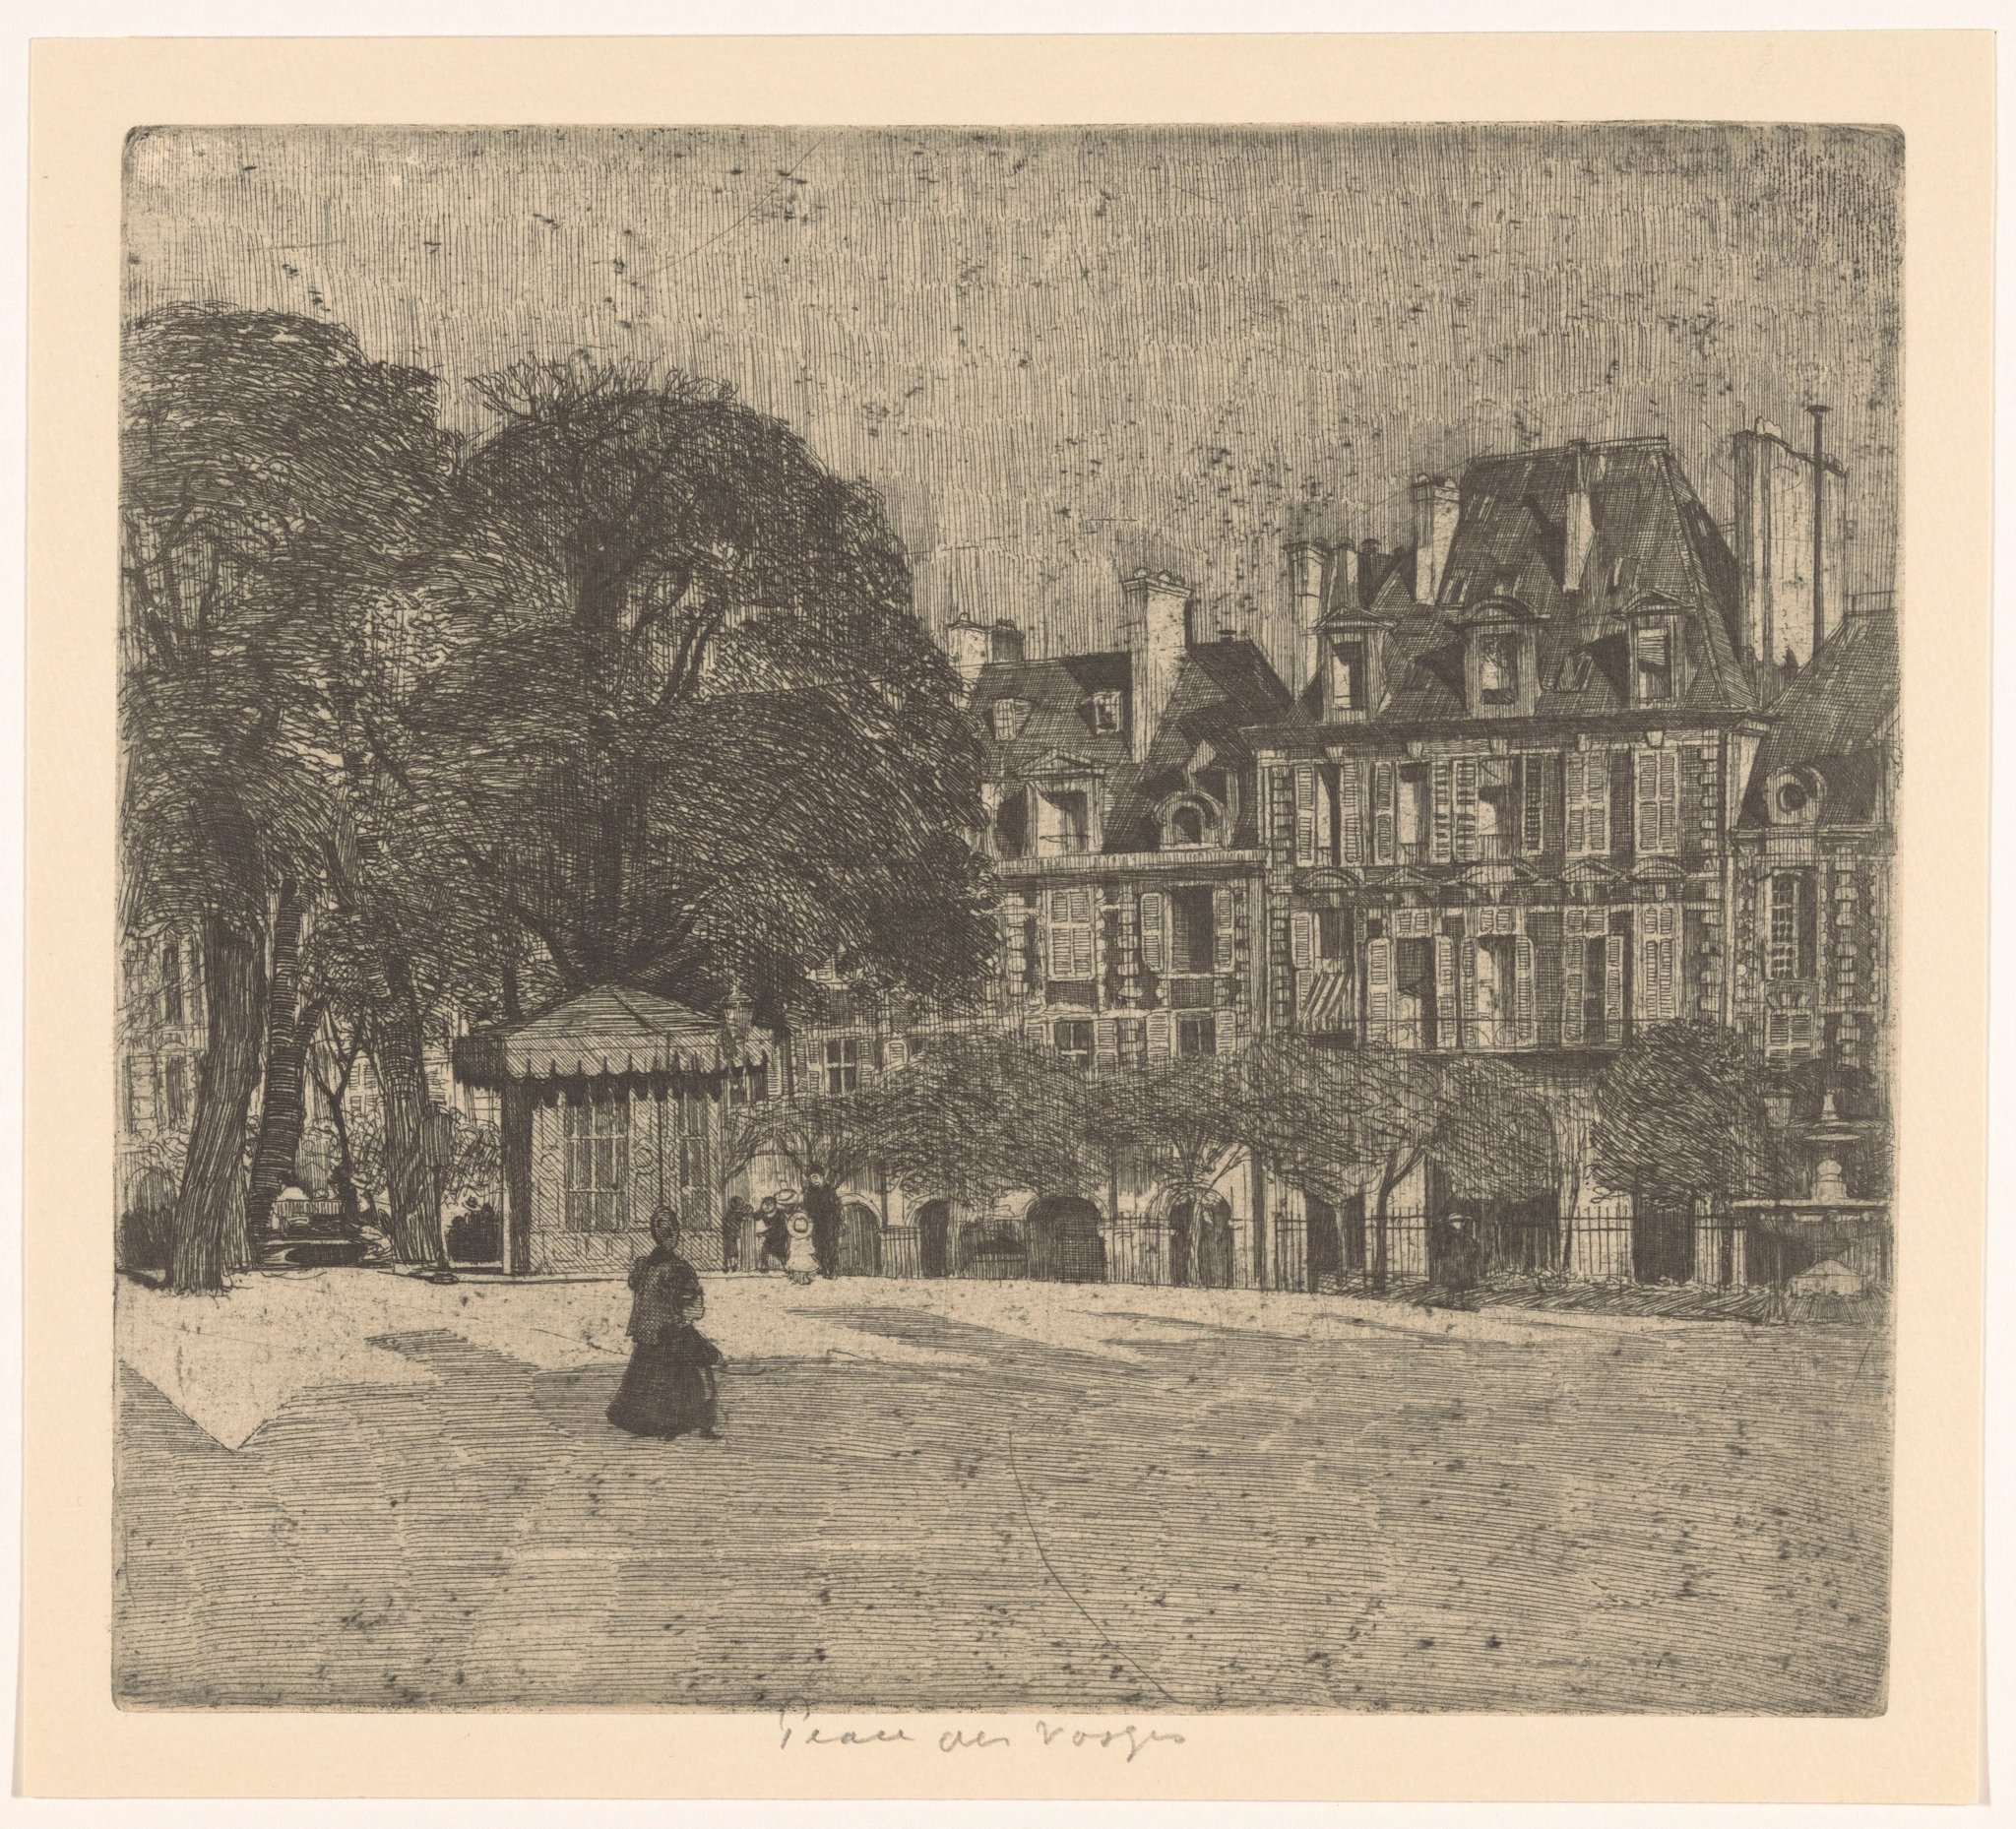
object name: print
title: Place des Vosges in Parijs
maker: martin monnickendam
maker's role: draughtsman, painter, print maker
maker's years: 1874-1943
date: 1896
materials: paper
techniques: etching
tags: square, place, circus, etc.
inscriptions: collector's mark: Lugt 2228